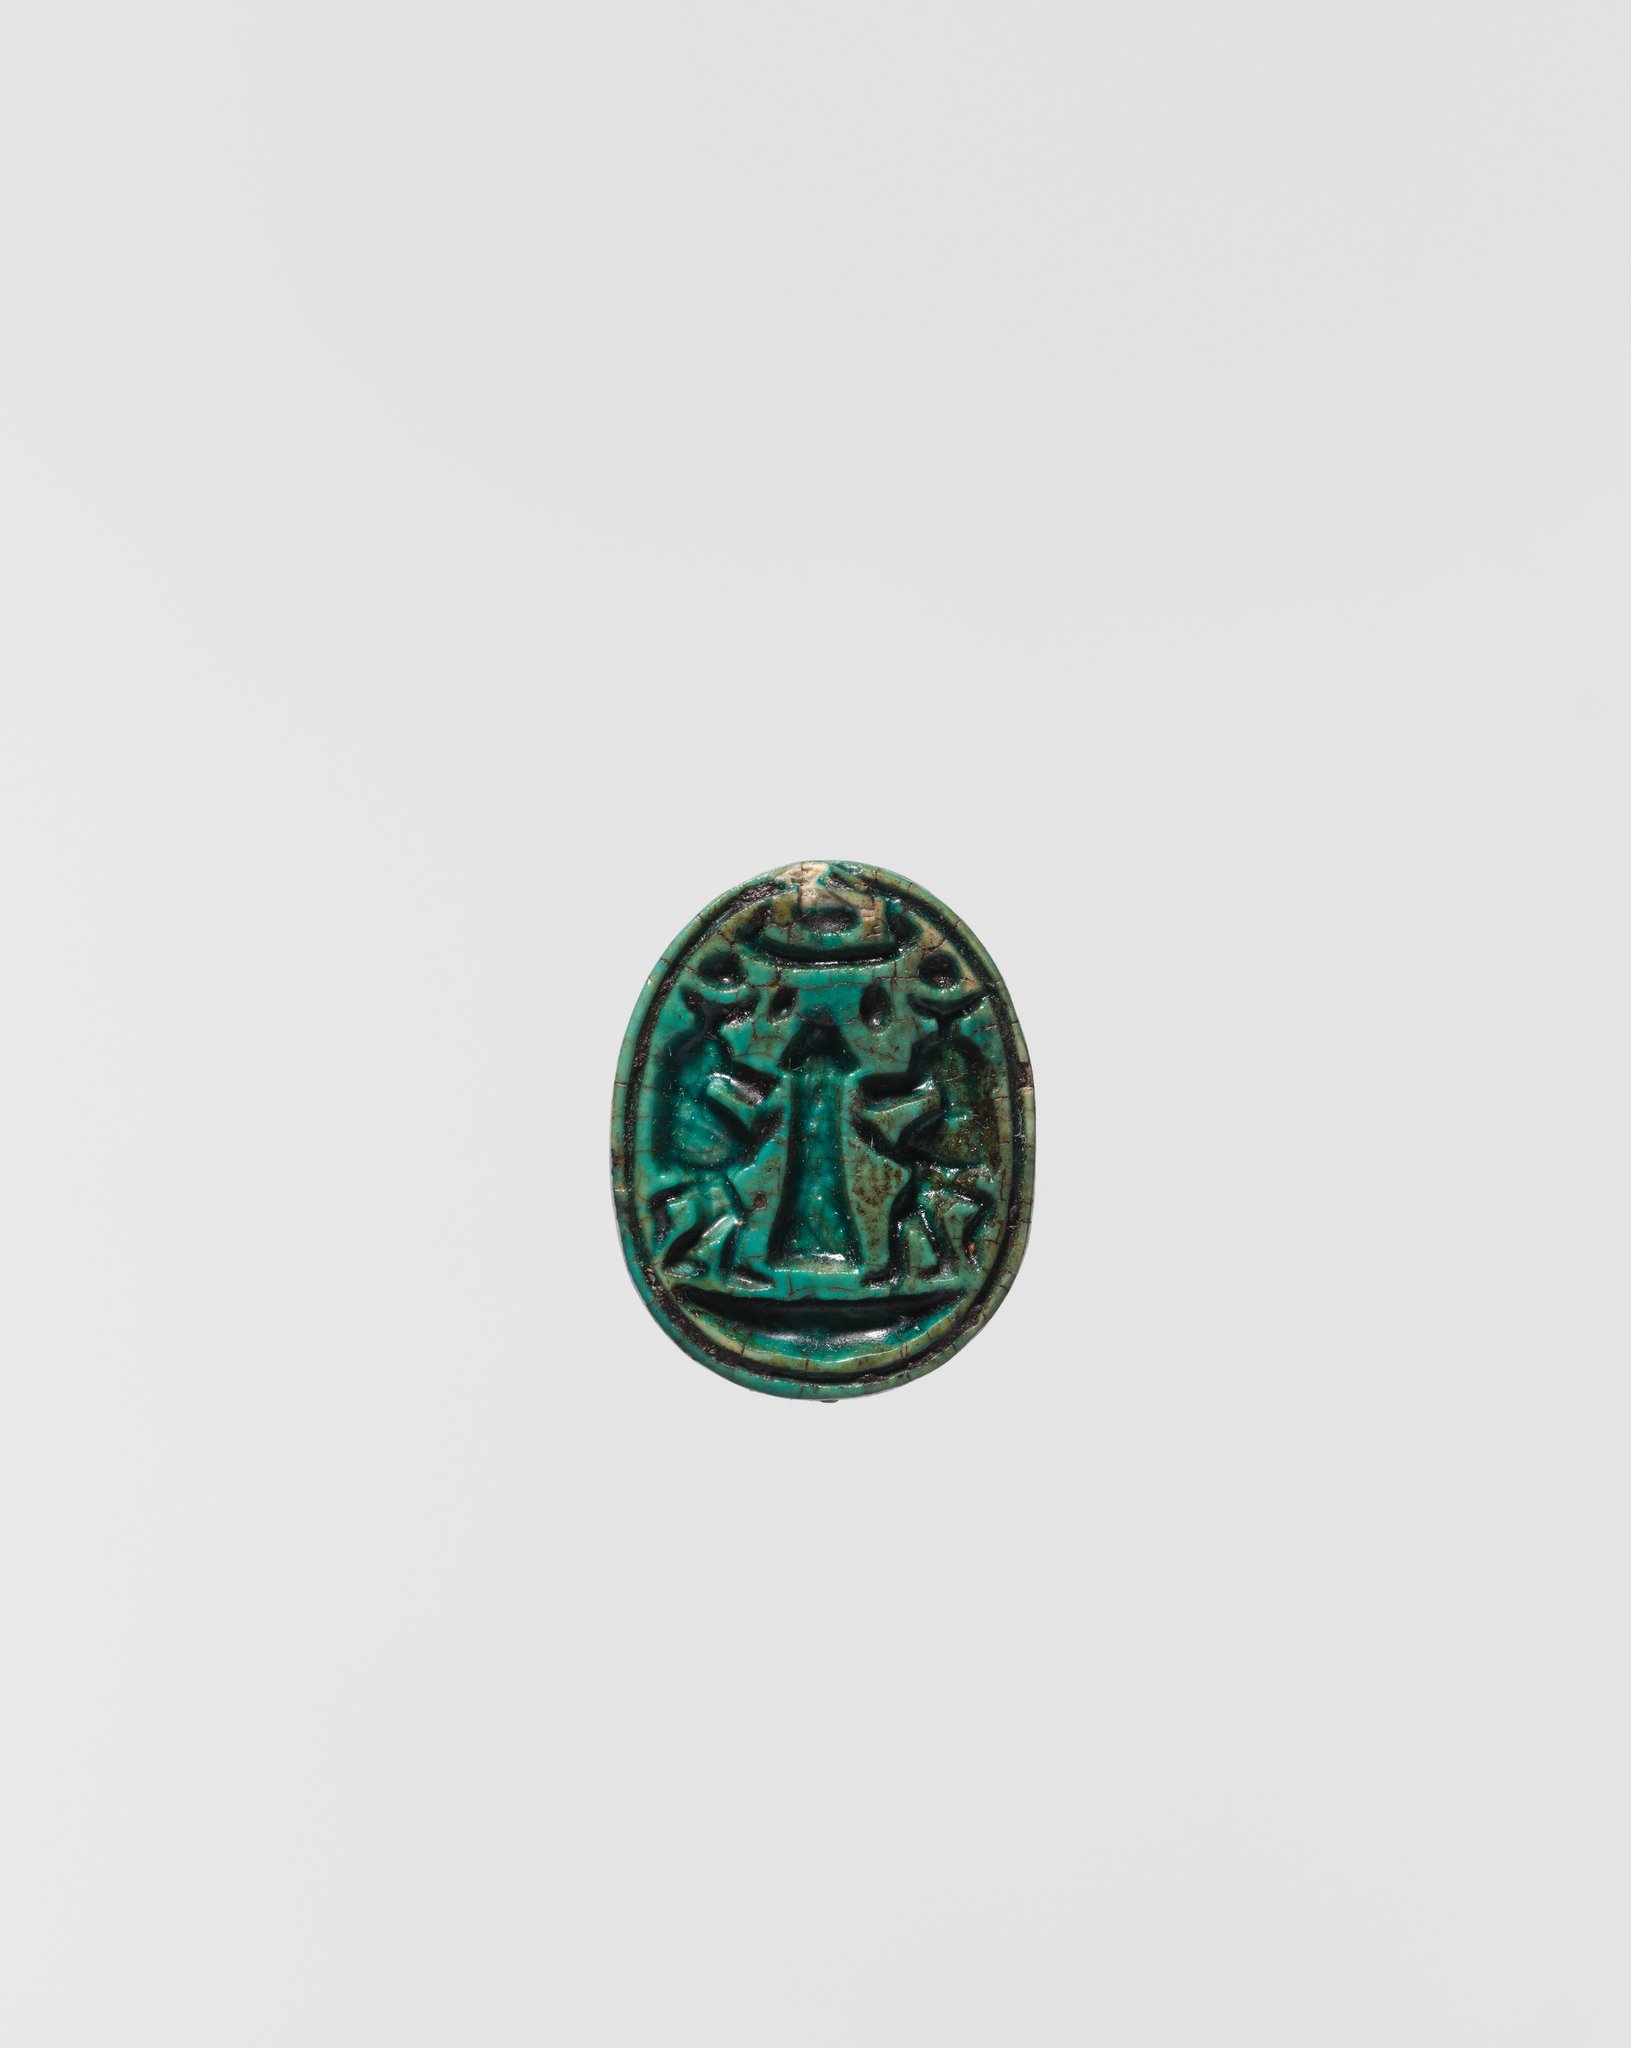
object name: scarab, thoth, baboon, obelisk, amun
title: Scarab with Baboons of Thoth Adoring Amun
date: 1295-1070 BCE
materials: stone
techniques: glazing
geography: egypt